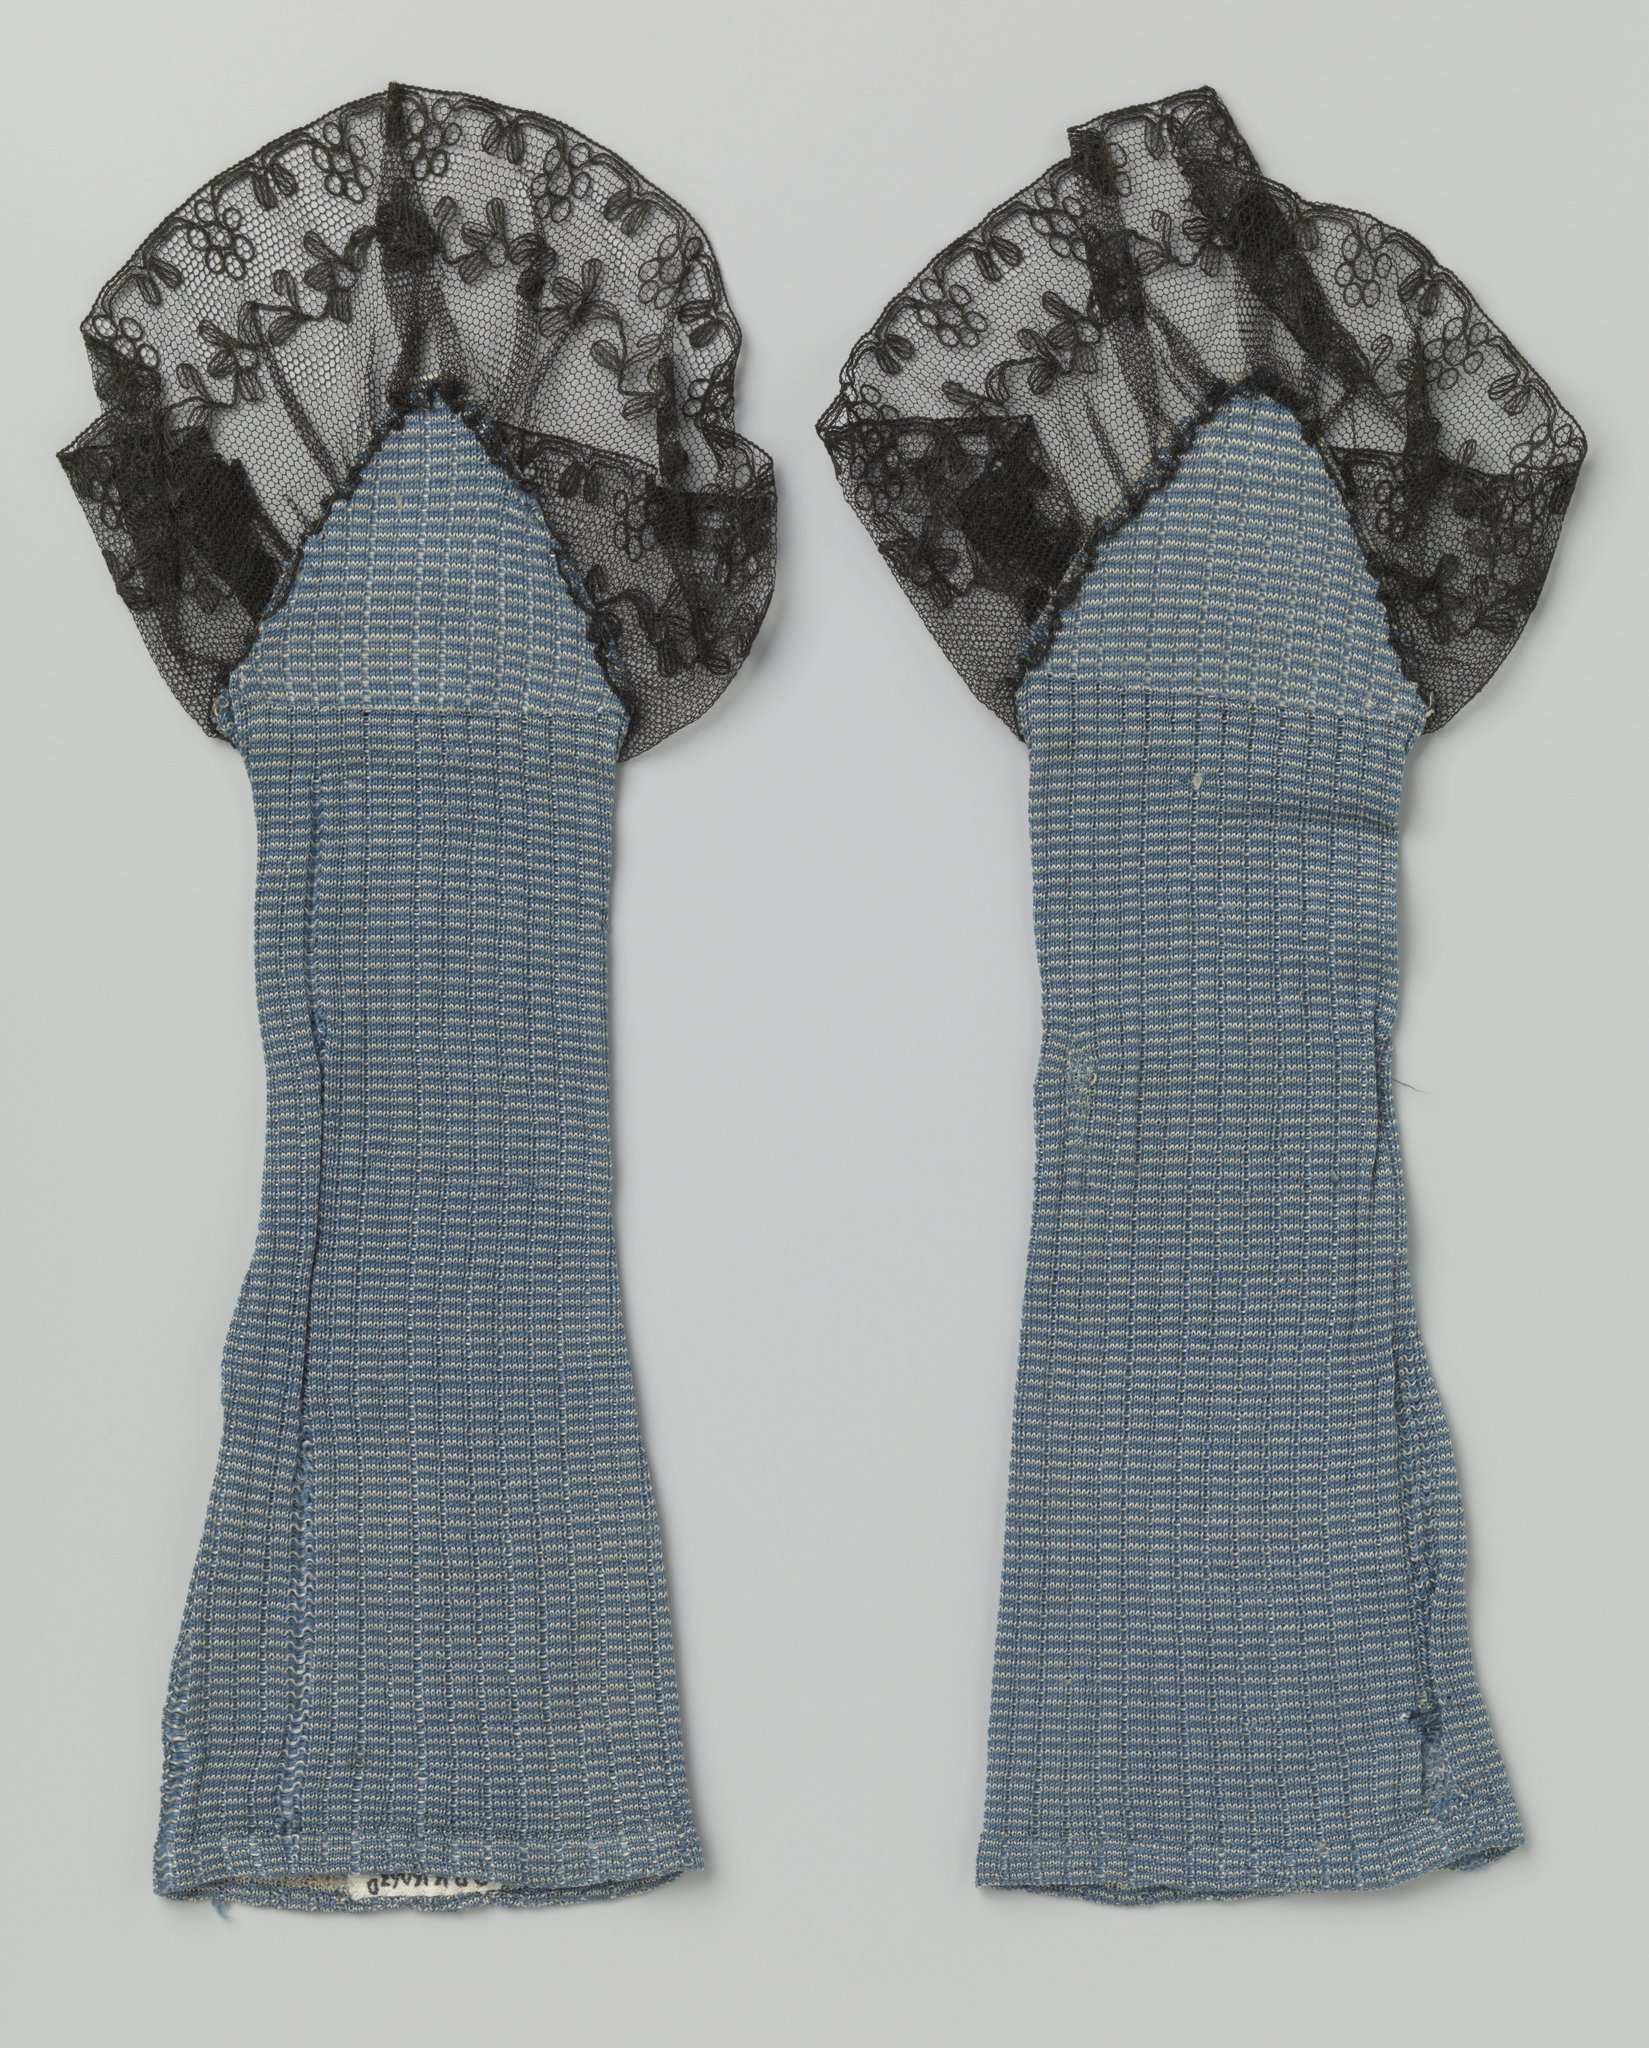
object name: clothing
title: Mitaine van blauwe zijden tricot en gerimpelde strook zwarte machinale kant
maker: Anonymous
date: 1775-1800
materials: silk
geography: zaanstreek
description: Mitaine van blauwe zijden tricot en gerimpelde strook zwarte machinale kant. Deel van een paar.